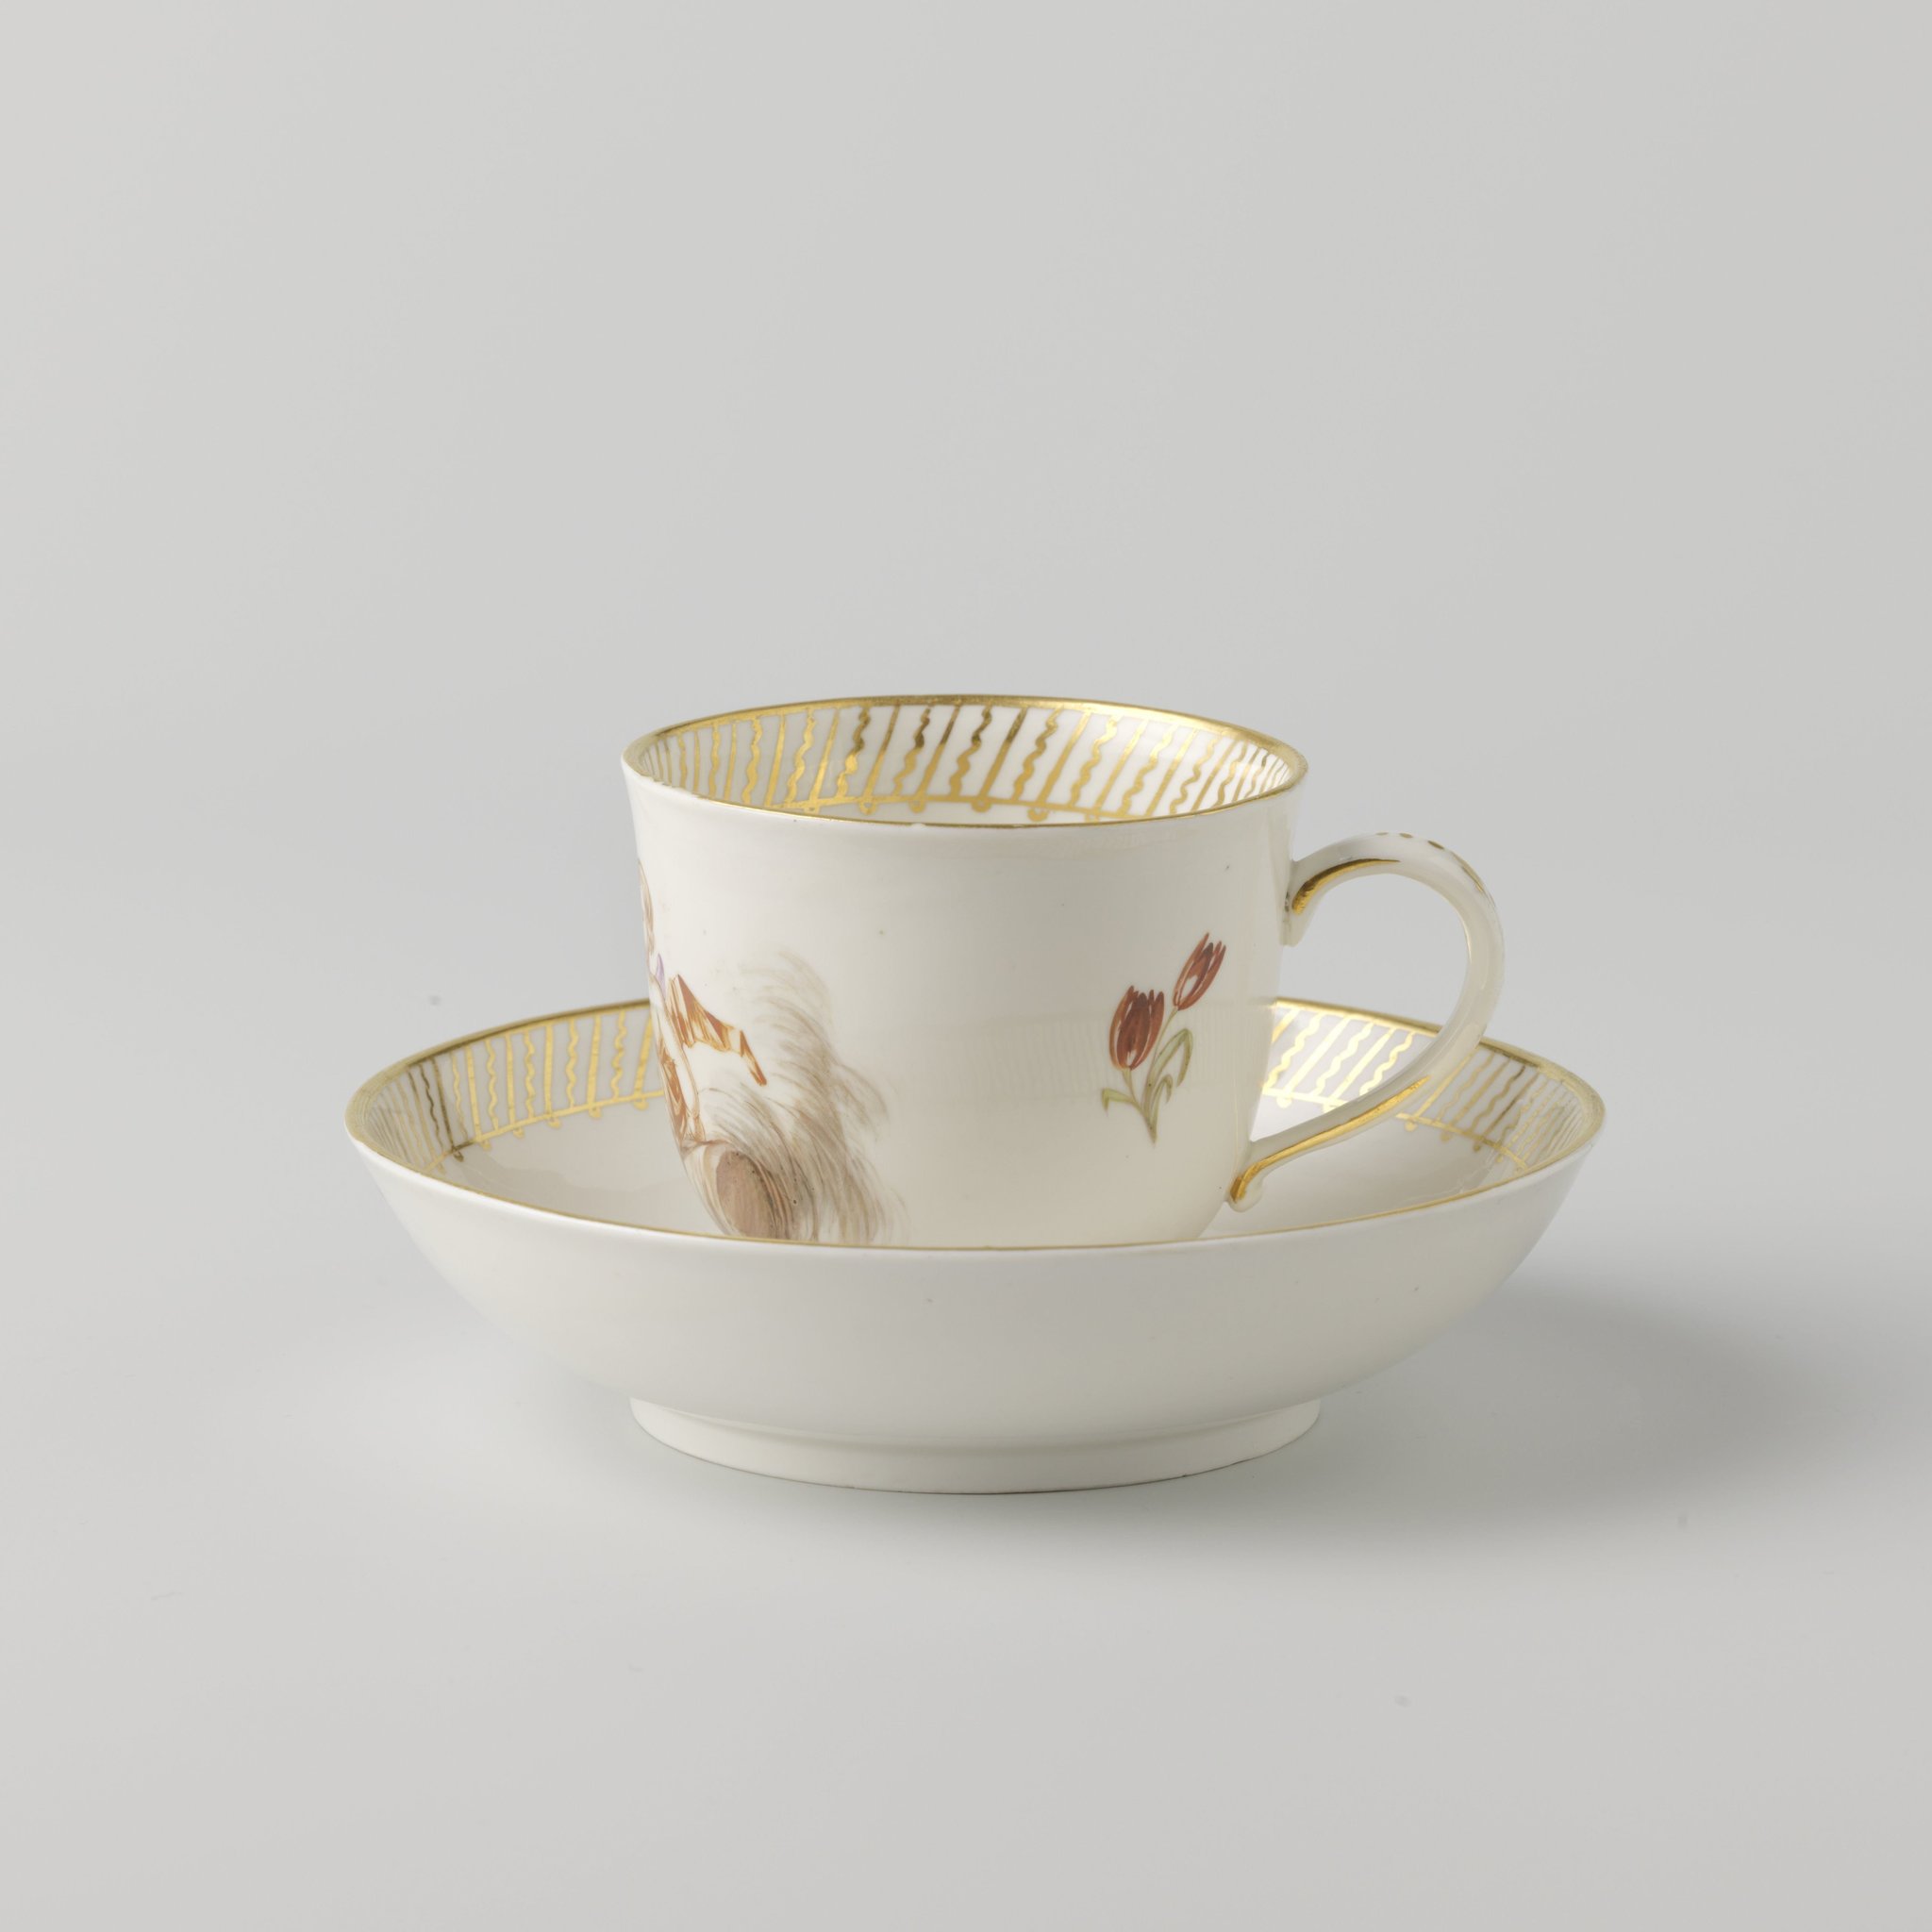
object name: kop en schotel, kop en schotel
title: Cup and saucer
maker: Anonymous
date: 1777-1790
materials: porcelain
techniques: painted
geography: ansbach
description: Ansbach painted decoration: Porseleinfabriek Den Haag, 1777–1790 hard-paste porcelain